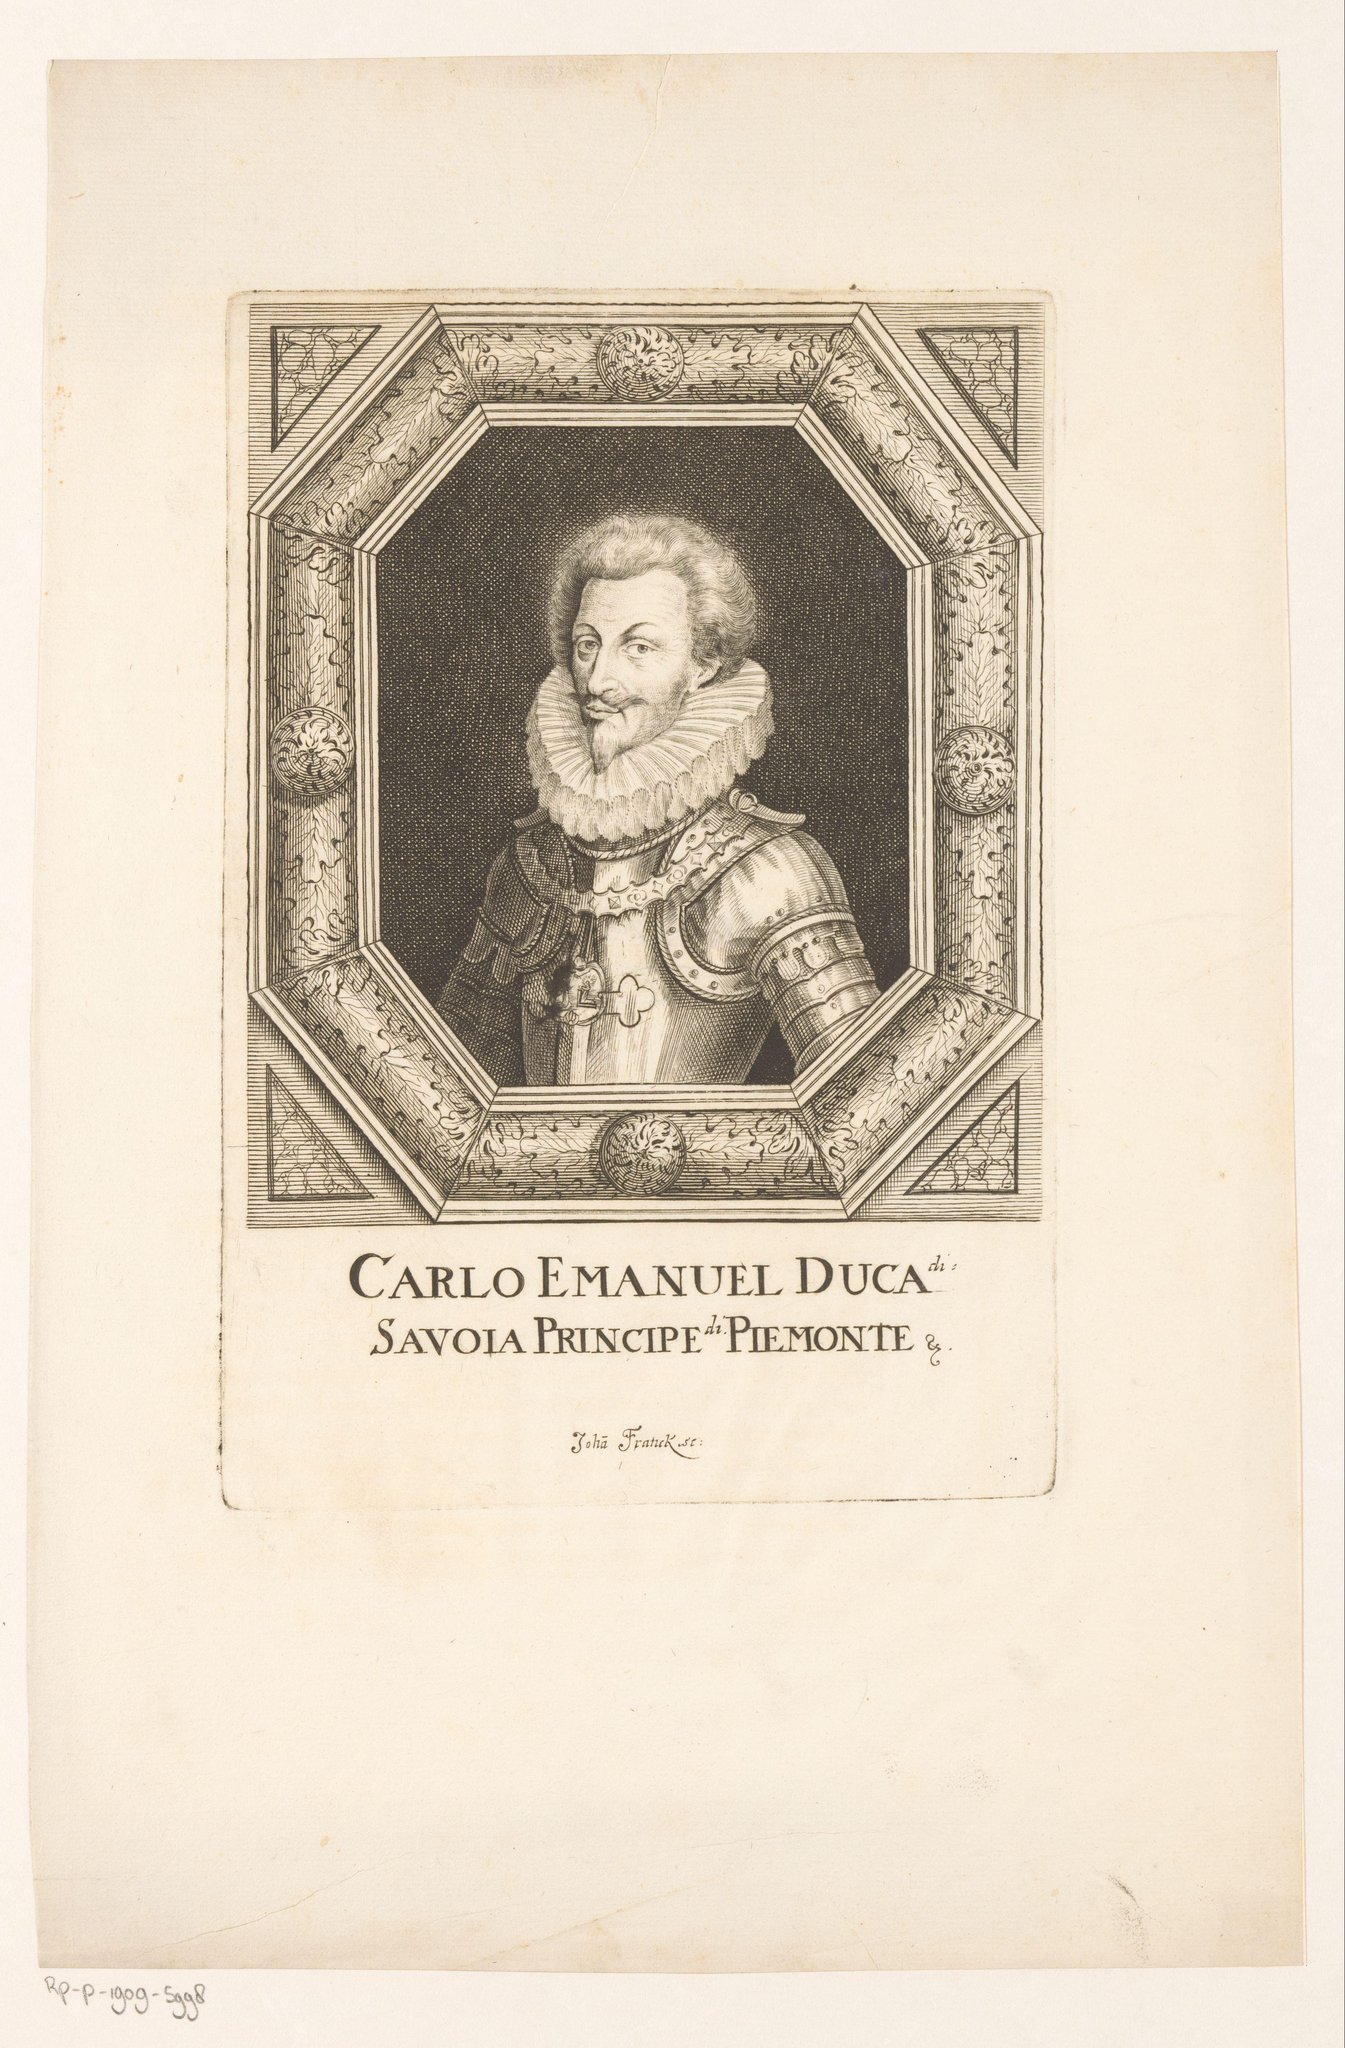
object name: print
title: Portret van Karel Emanuel I van Savoye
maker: johann franck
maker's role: print maker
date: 1650-1699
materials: paper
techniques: engraving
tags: armour, historical persons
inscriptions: collector's mark: Lugt 2228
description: Prent gebruikt voor: Priorato, Galeazzo Gualdo. Historia di Ferdinando terzo. Wenen: s.n., 1672.